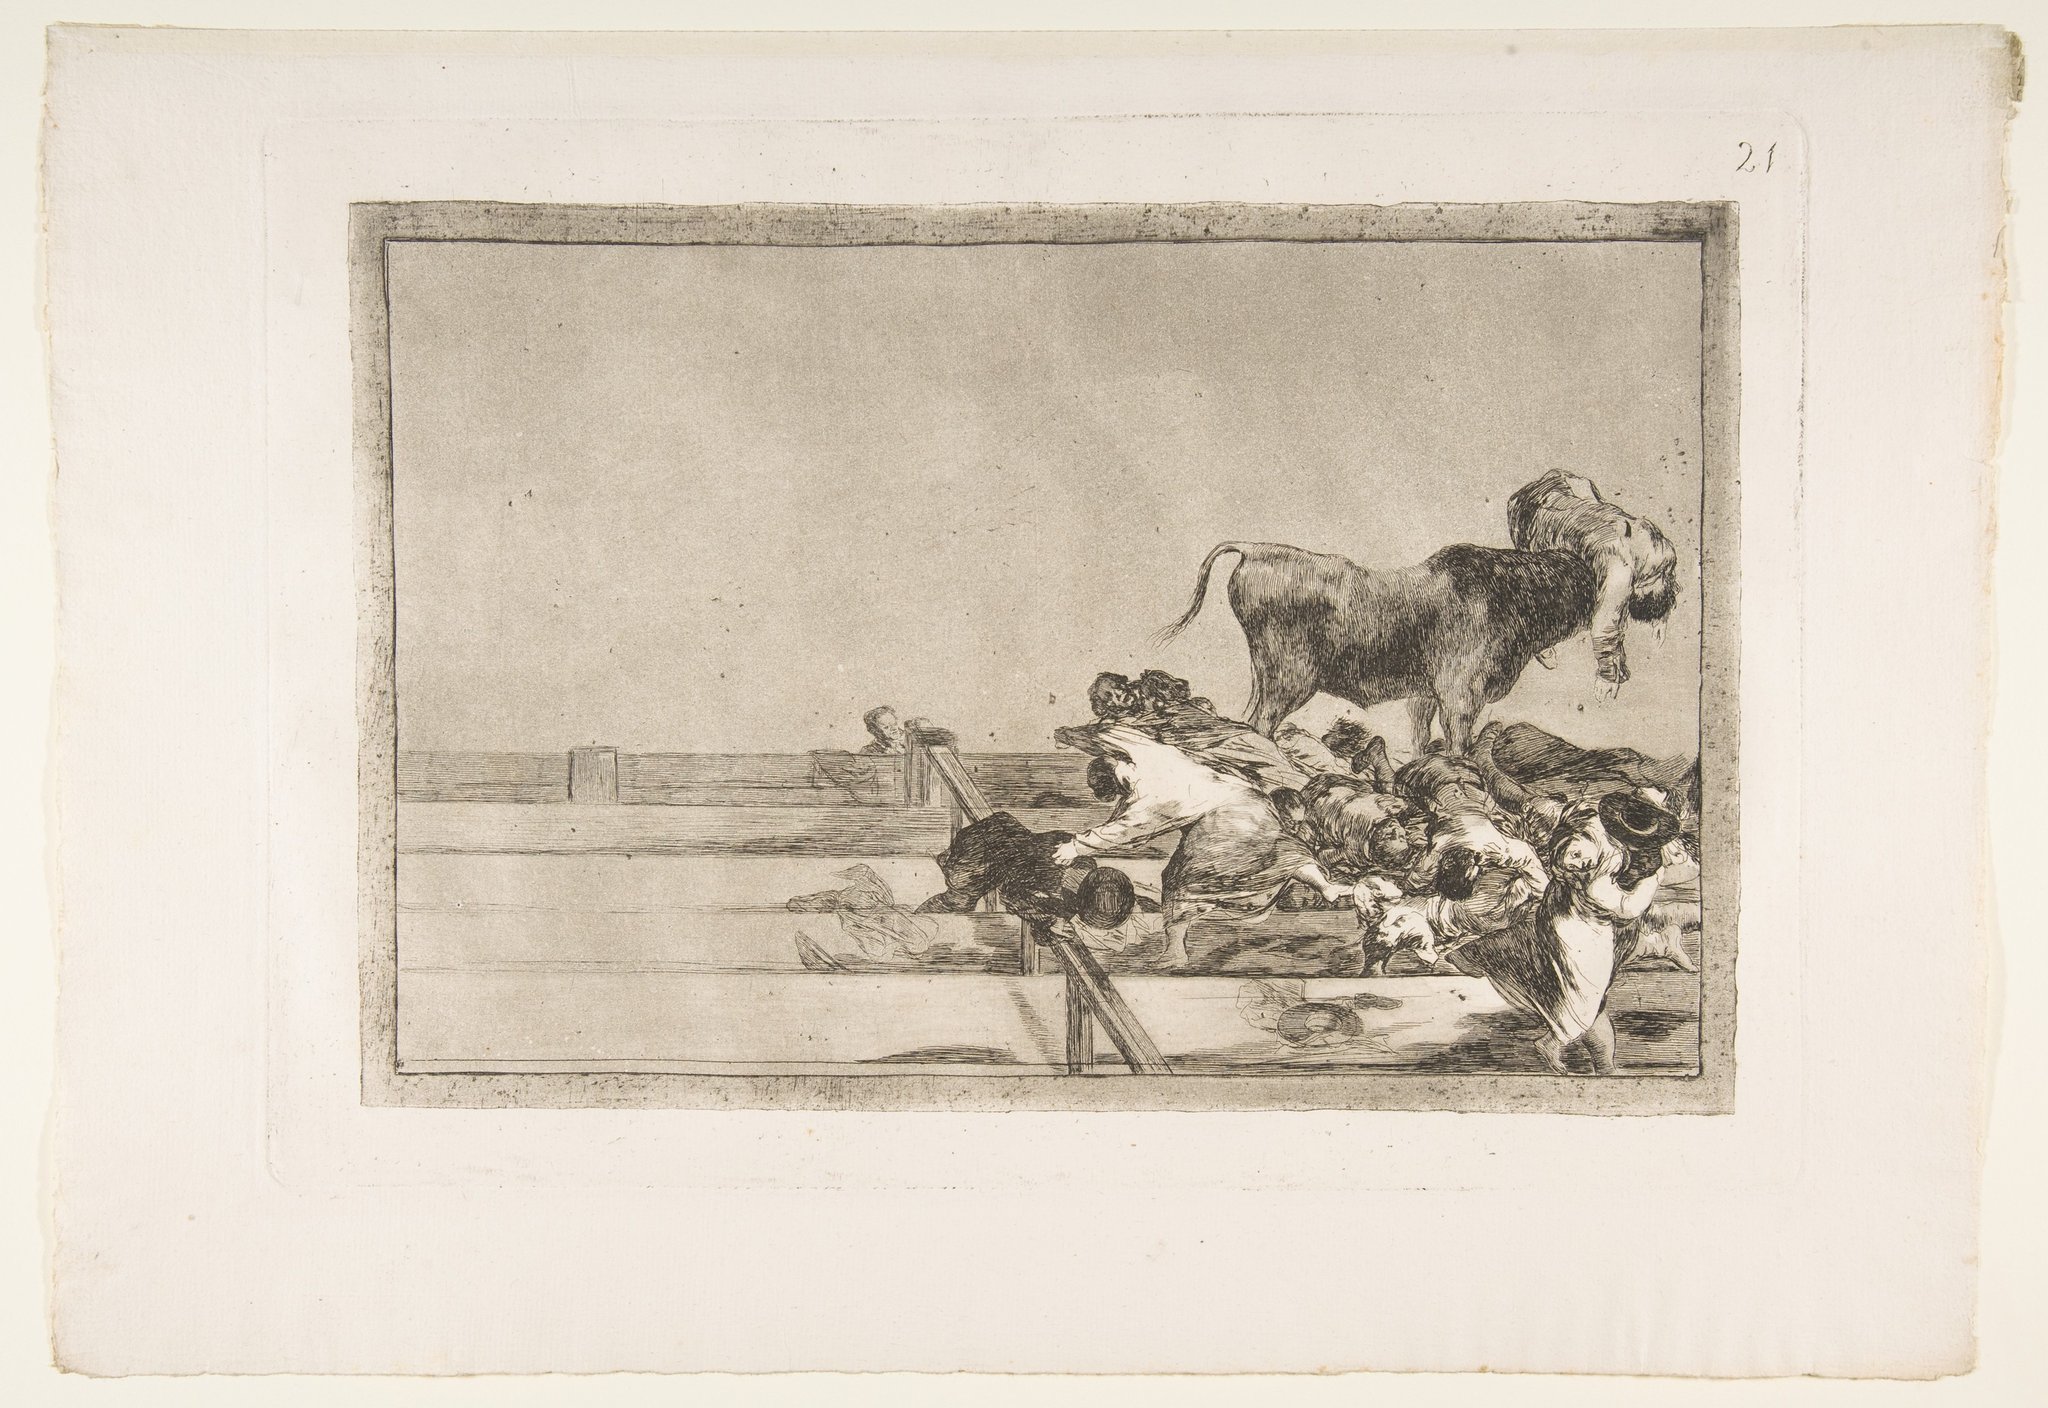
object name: print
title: Plate 21 from "La Tauromaquia": Dreadful events in the front rows of the ring at Madrid and death of the mayor of Torrejon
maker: goya (francisco de goya y lucientes)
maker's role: artist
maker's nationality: spanish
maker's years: 1746-1828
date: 1816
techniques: aquatint, engraving, burnishing, drypoint, etching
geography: spain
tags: men,women,bulls